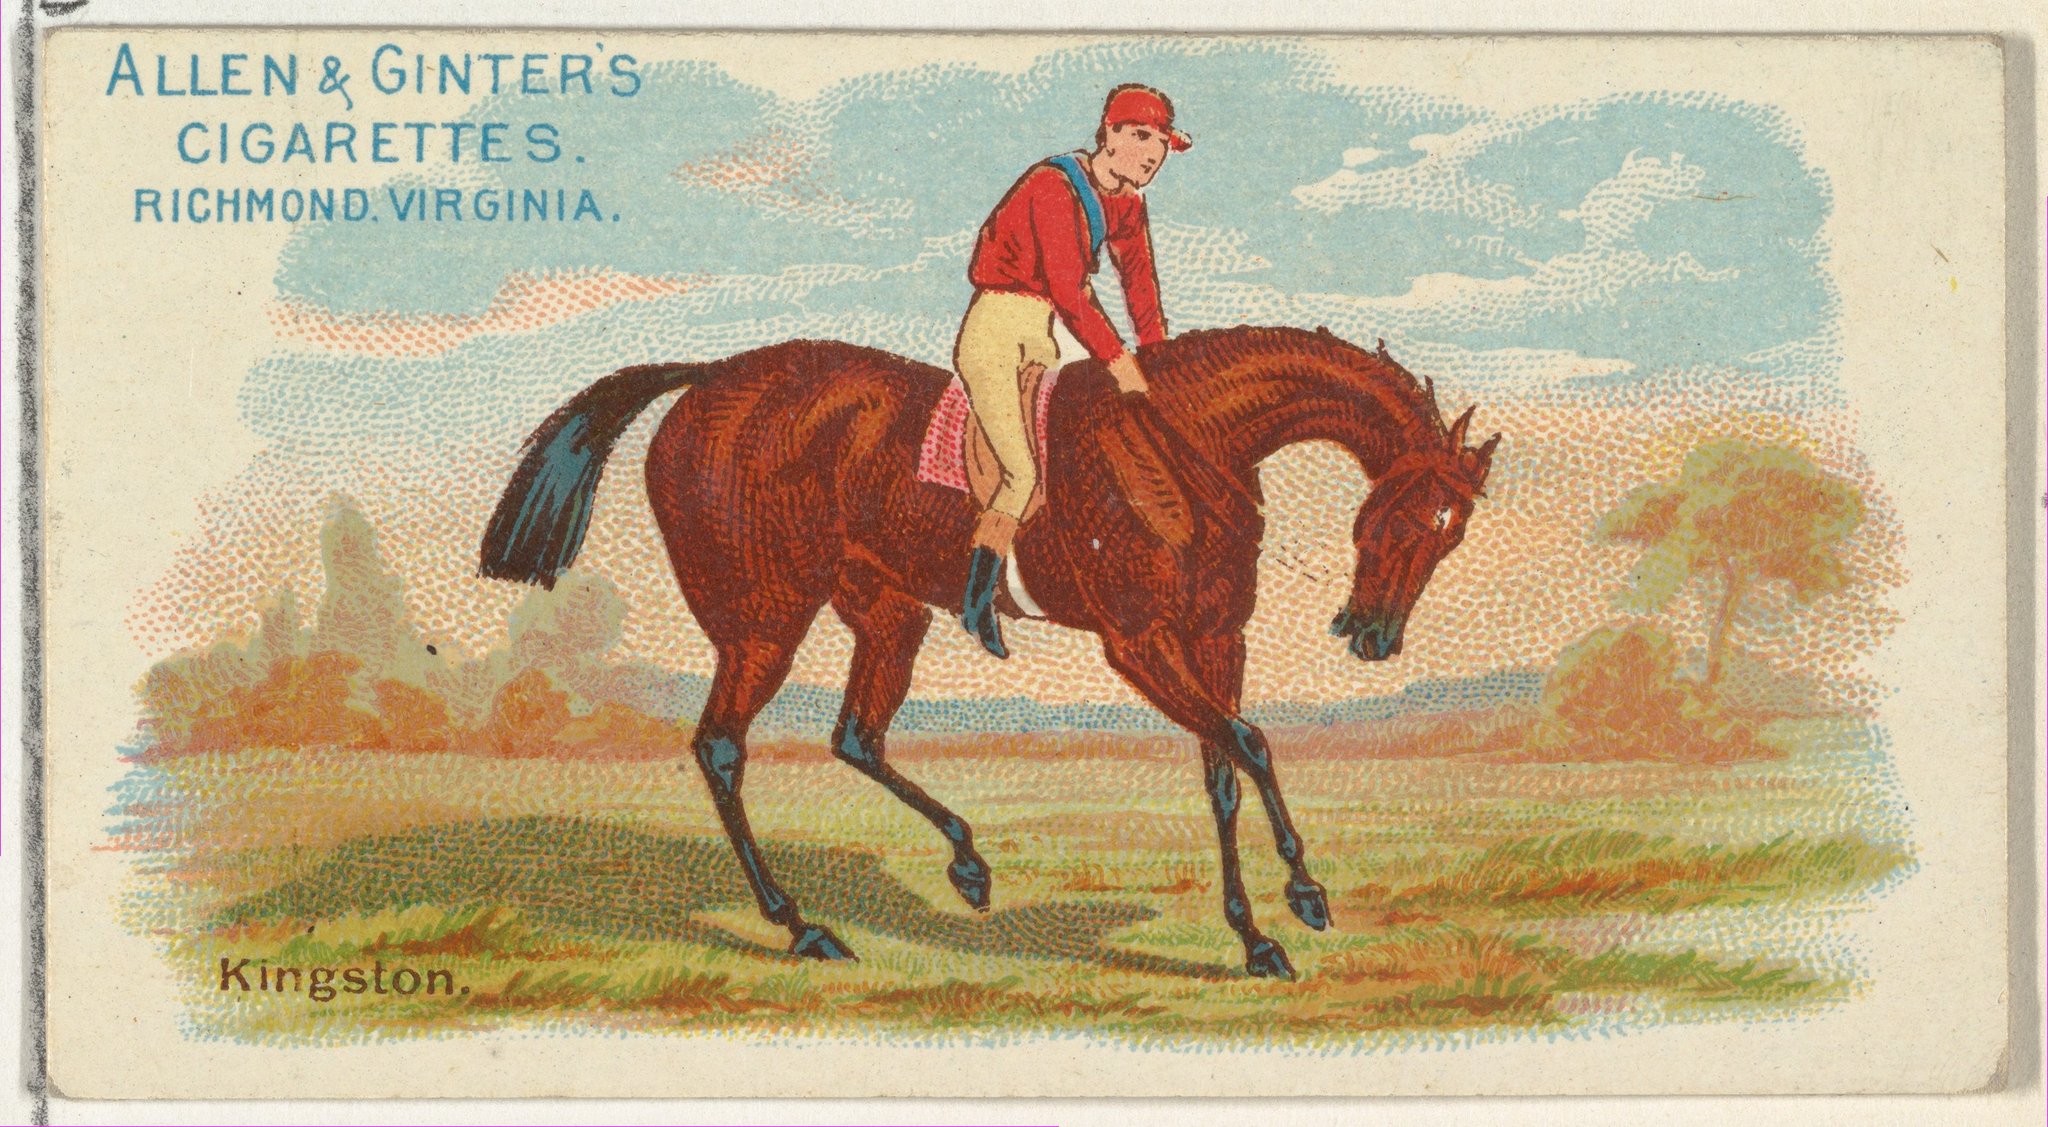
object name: print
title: Kingston, from The World's Racers series (N32) for Allen & Ginter Cigarettes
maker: allen & ginter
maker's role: publisher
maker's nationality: american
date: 1888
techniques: color lithograph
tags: men,horses,jockeys